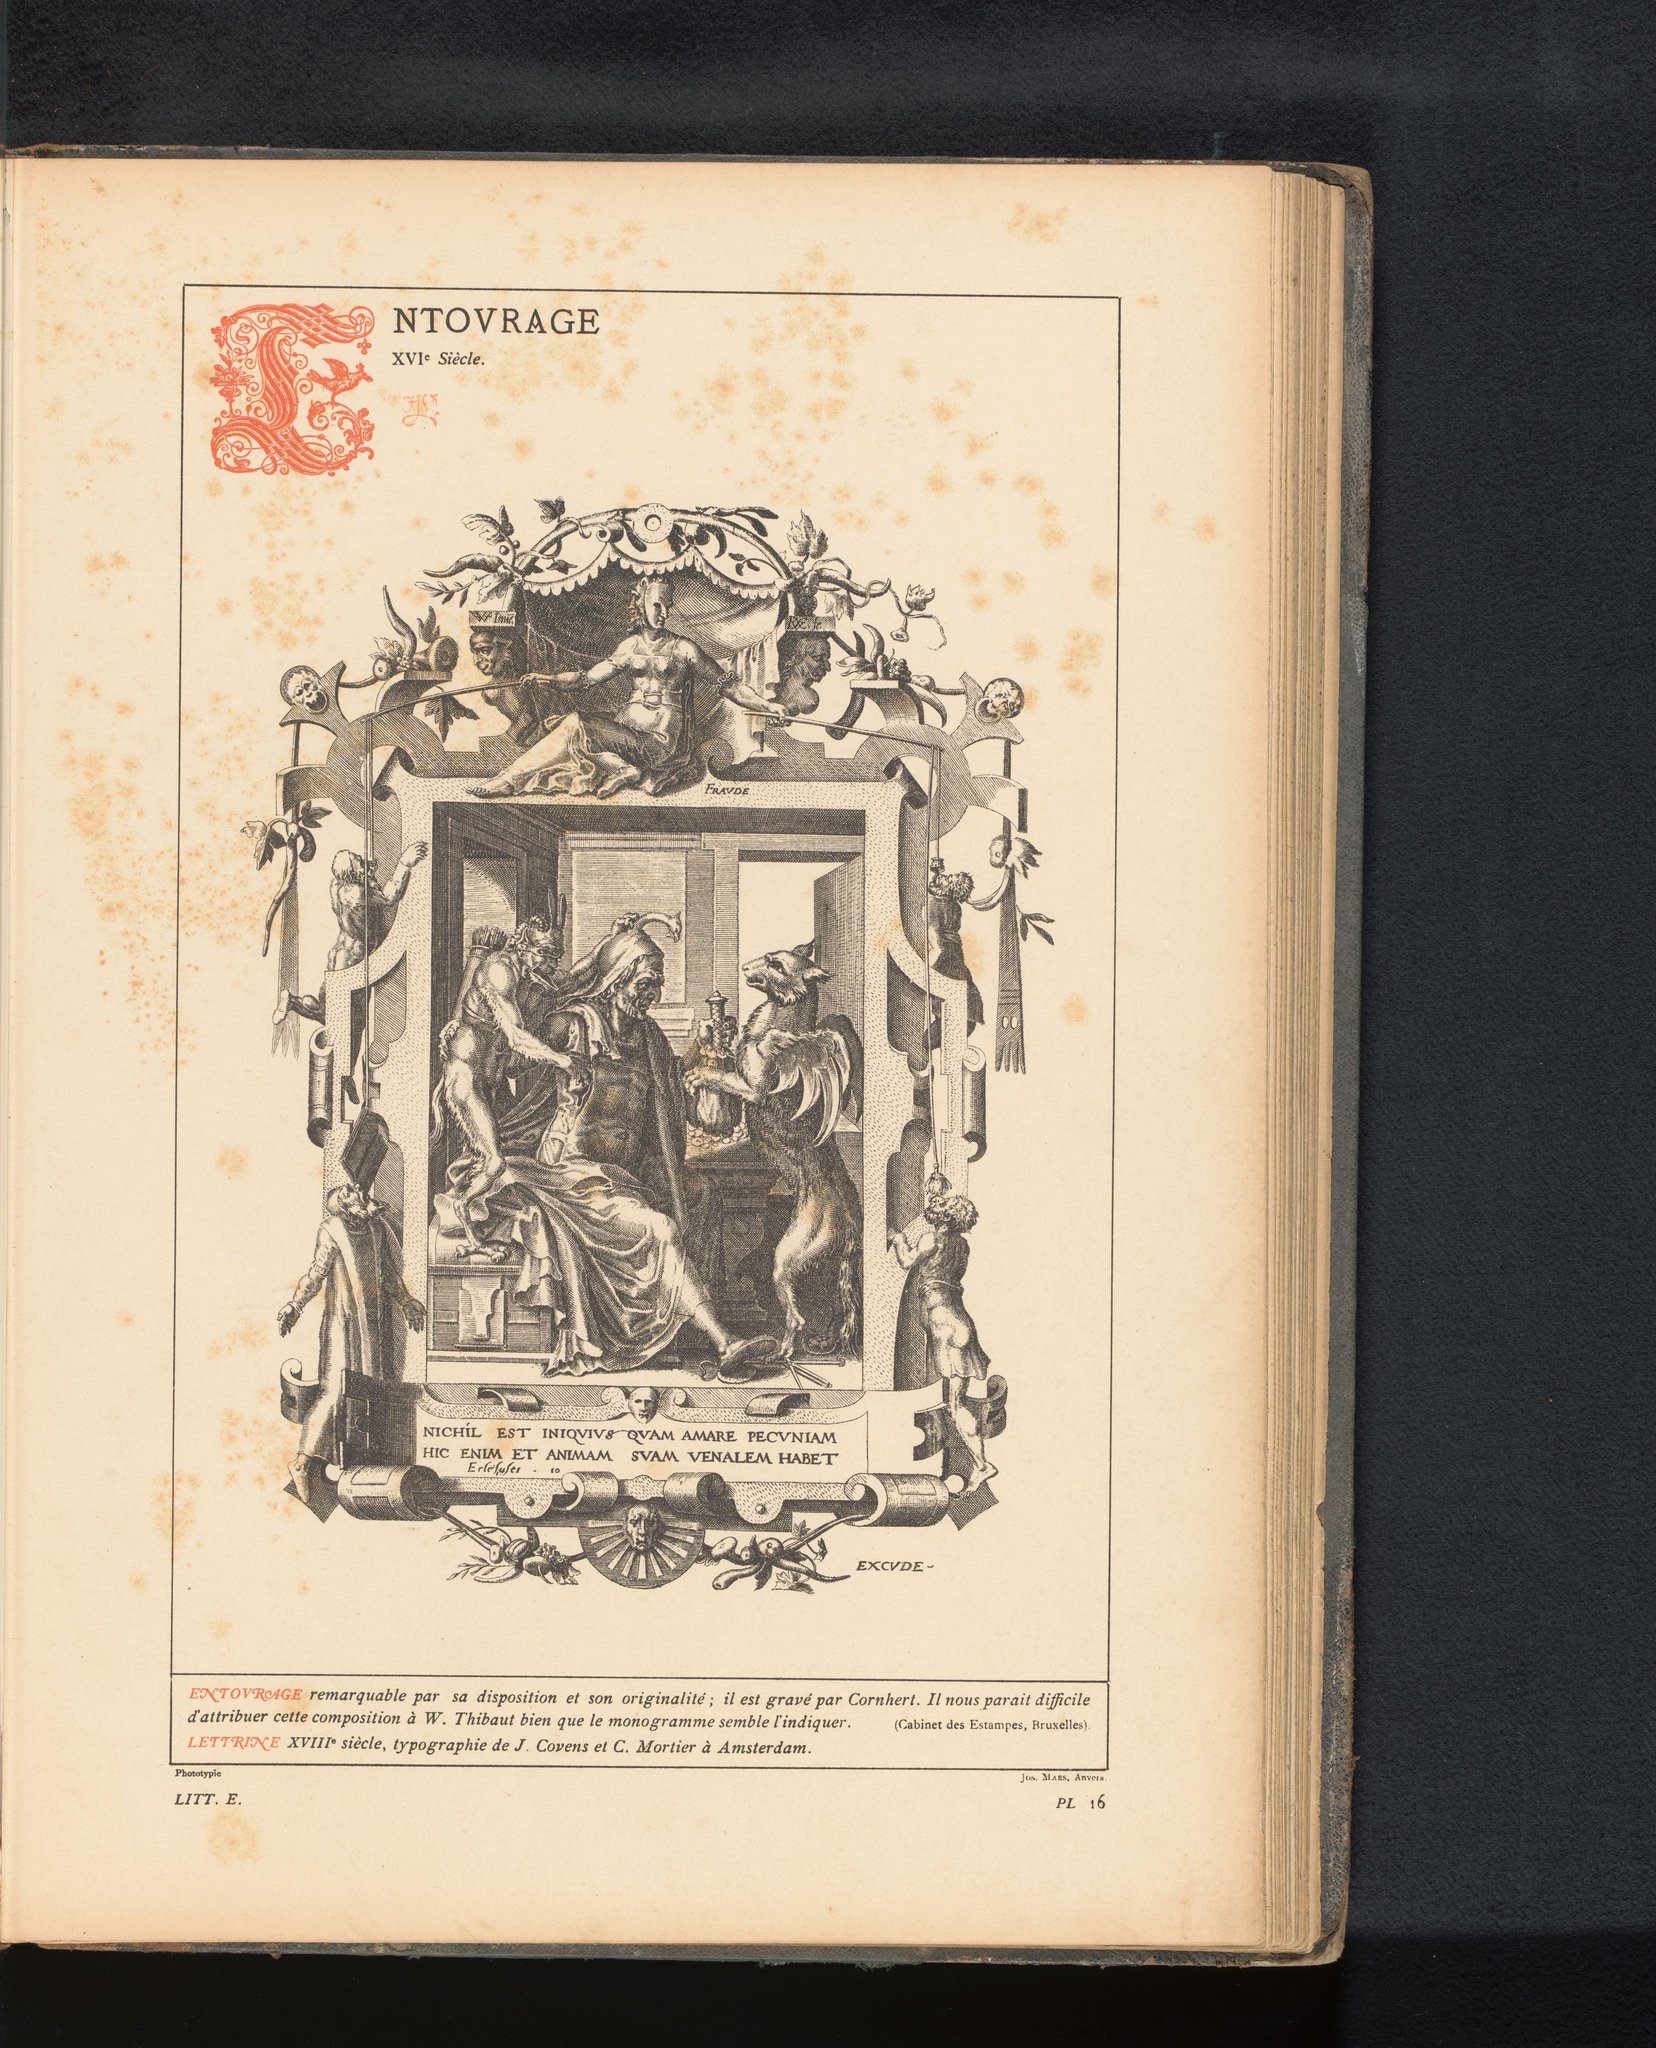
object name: photomechanical print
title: Reproductie van een prent van een man en twee fabelachtige wezens met een gedecoreerde rand door Dirck Volckertsz. Coornhert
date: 1875-1880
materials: paper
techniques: photolithography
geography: antwerp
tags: ornament ~ grotesque, fabulous animals (sometimes wrongly called 'grotesques'); 'mostri' (ripa), adult man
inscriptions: inscription: ‘LITT. E. - PL. 16’, inscription: ‘ENTOURAGE remarquable par (...)’, monogram: ‘JJvY’